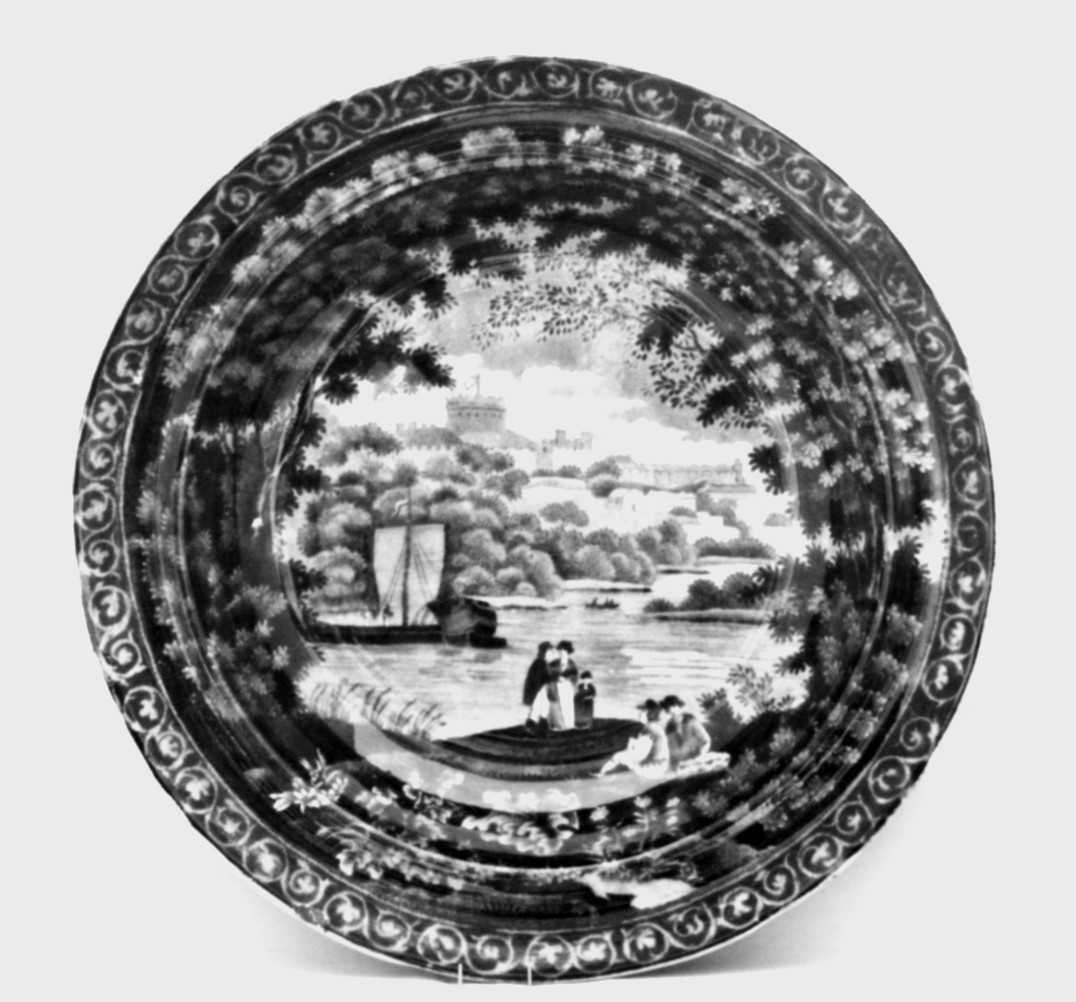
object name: soup plate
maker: james and ralph clews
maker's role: factory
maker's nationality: british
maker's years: 1813-1836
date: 1801-1900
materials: pottery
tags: landscapes,boats